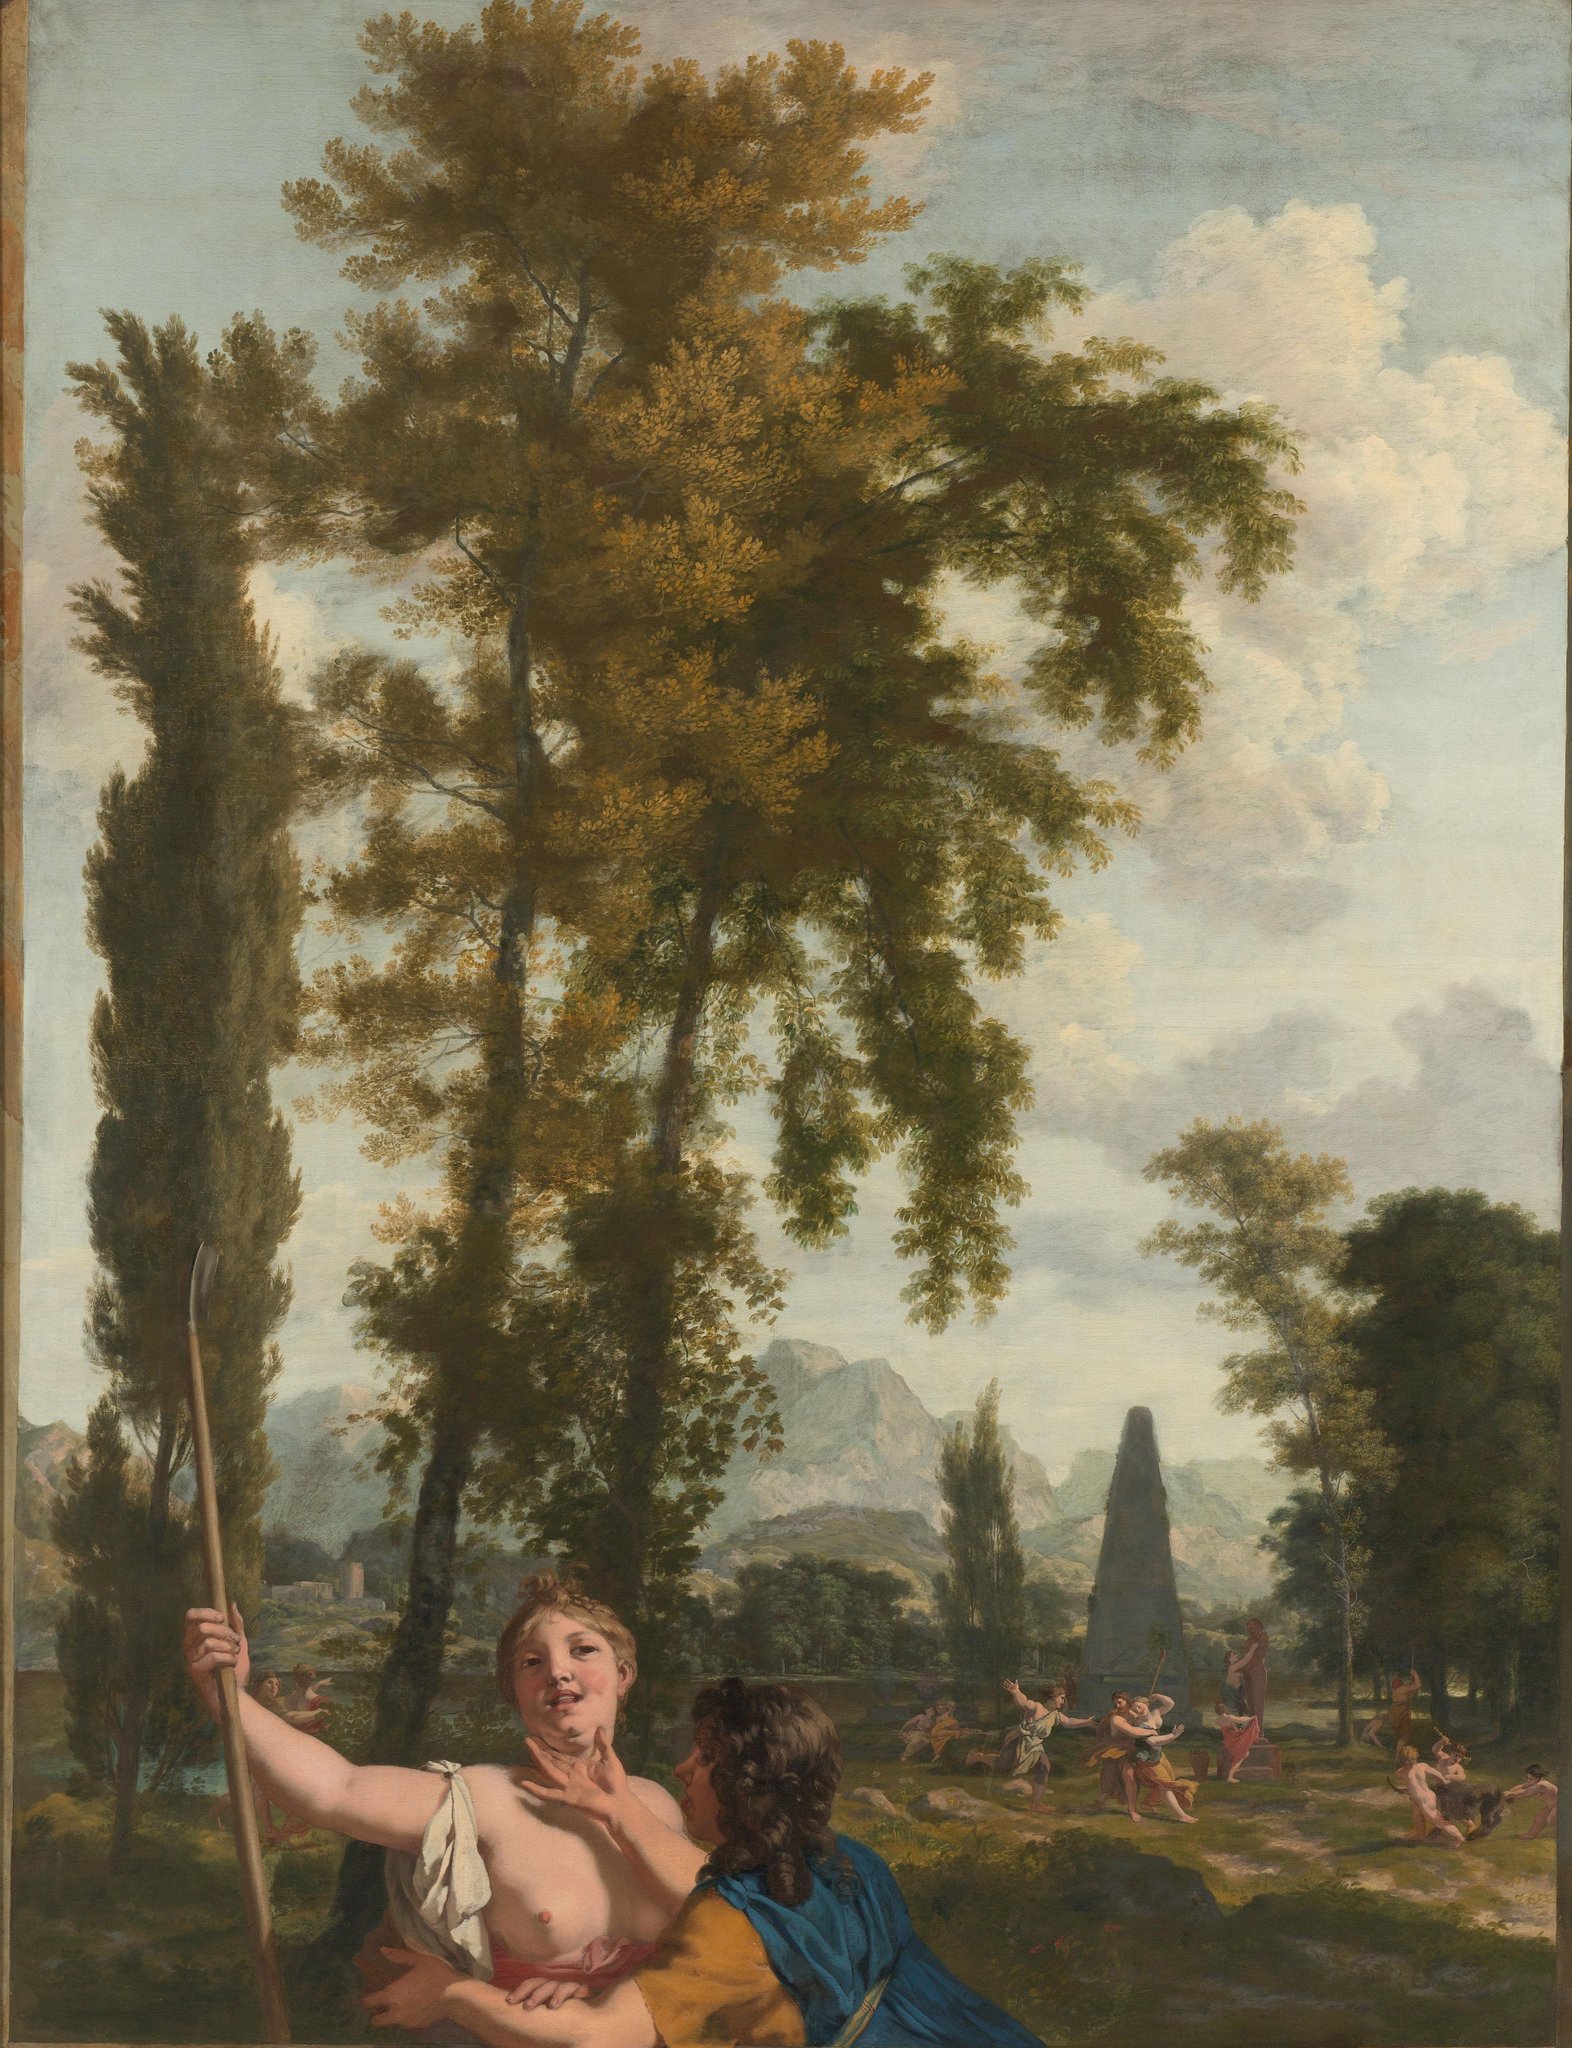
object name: painting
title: Decoration for a Room in the House of Jacob de Flines in Amsterdam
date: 1687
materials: canvas, oil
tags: herding, herdsman, herdswoman, shepherd, shepherdess, cowherd, etc., pastorals, arcadian scenes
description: Gerard Lairesse (1641 - 1711) and Johannes Glauber (1646 - c. 1726). Italian landscape with shepherd and shepherdess.